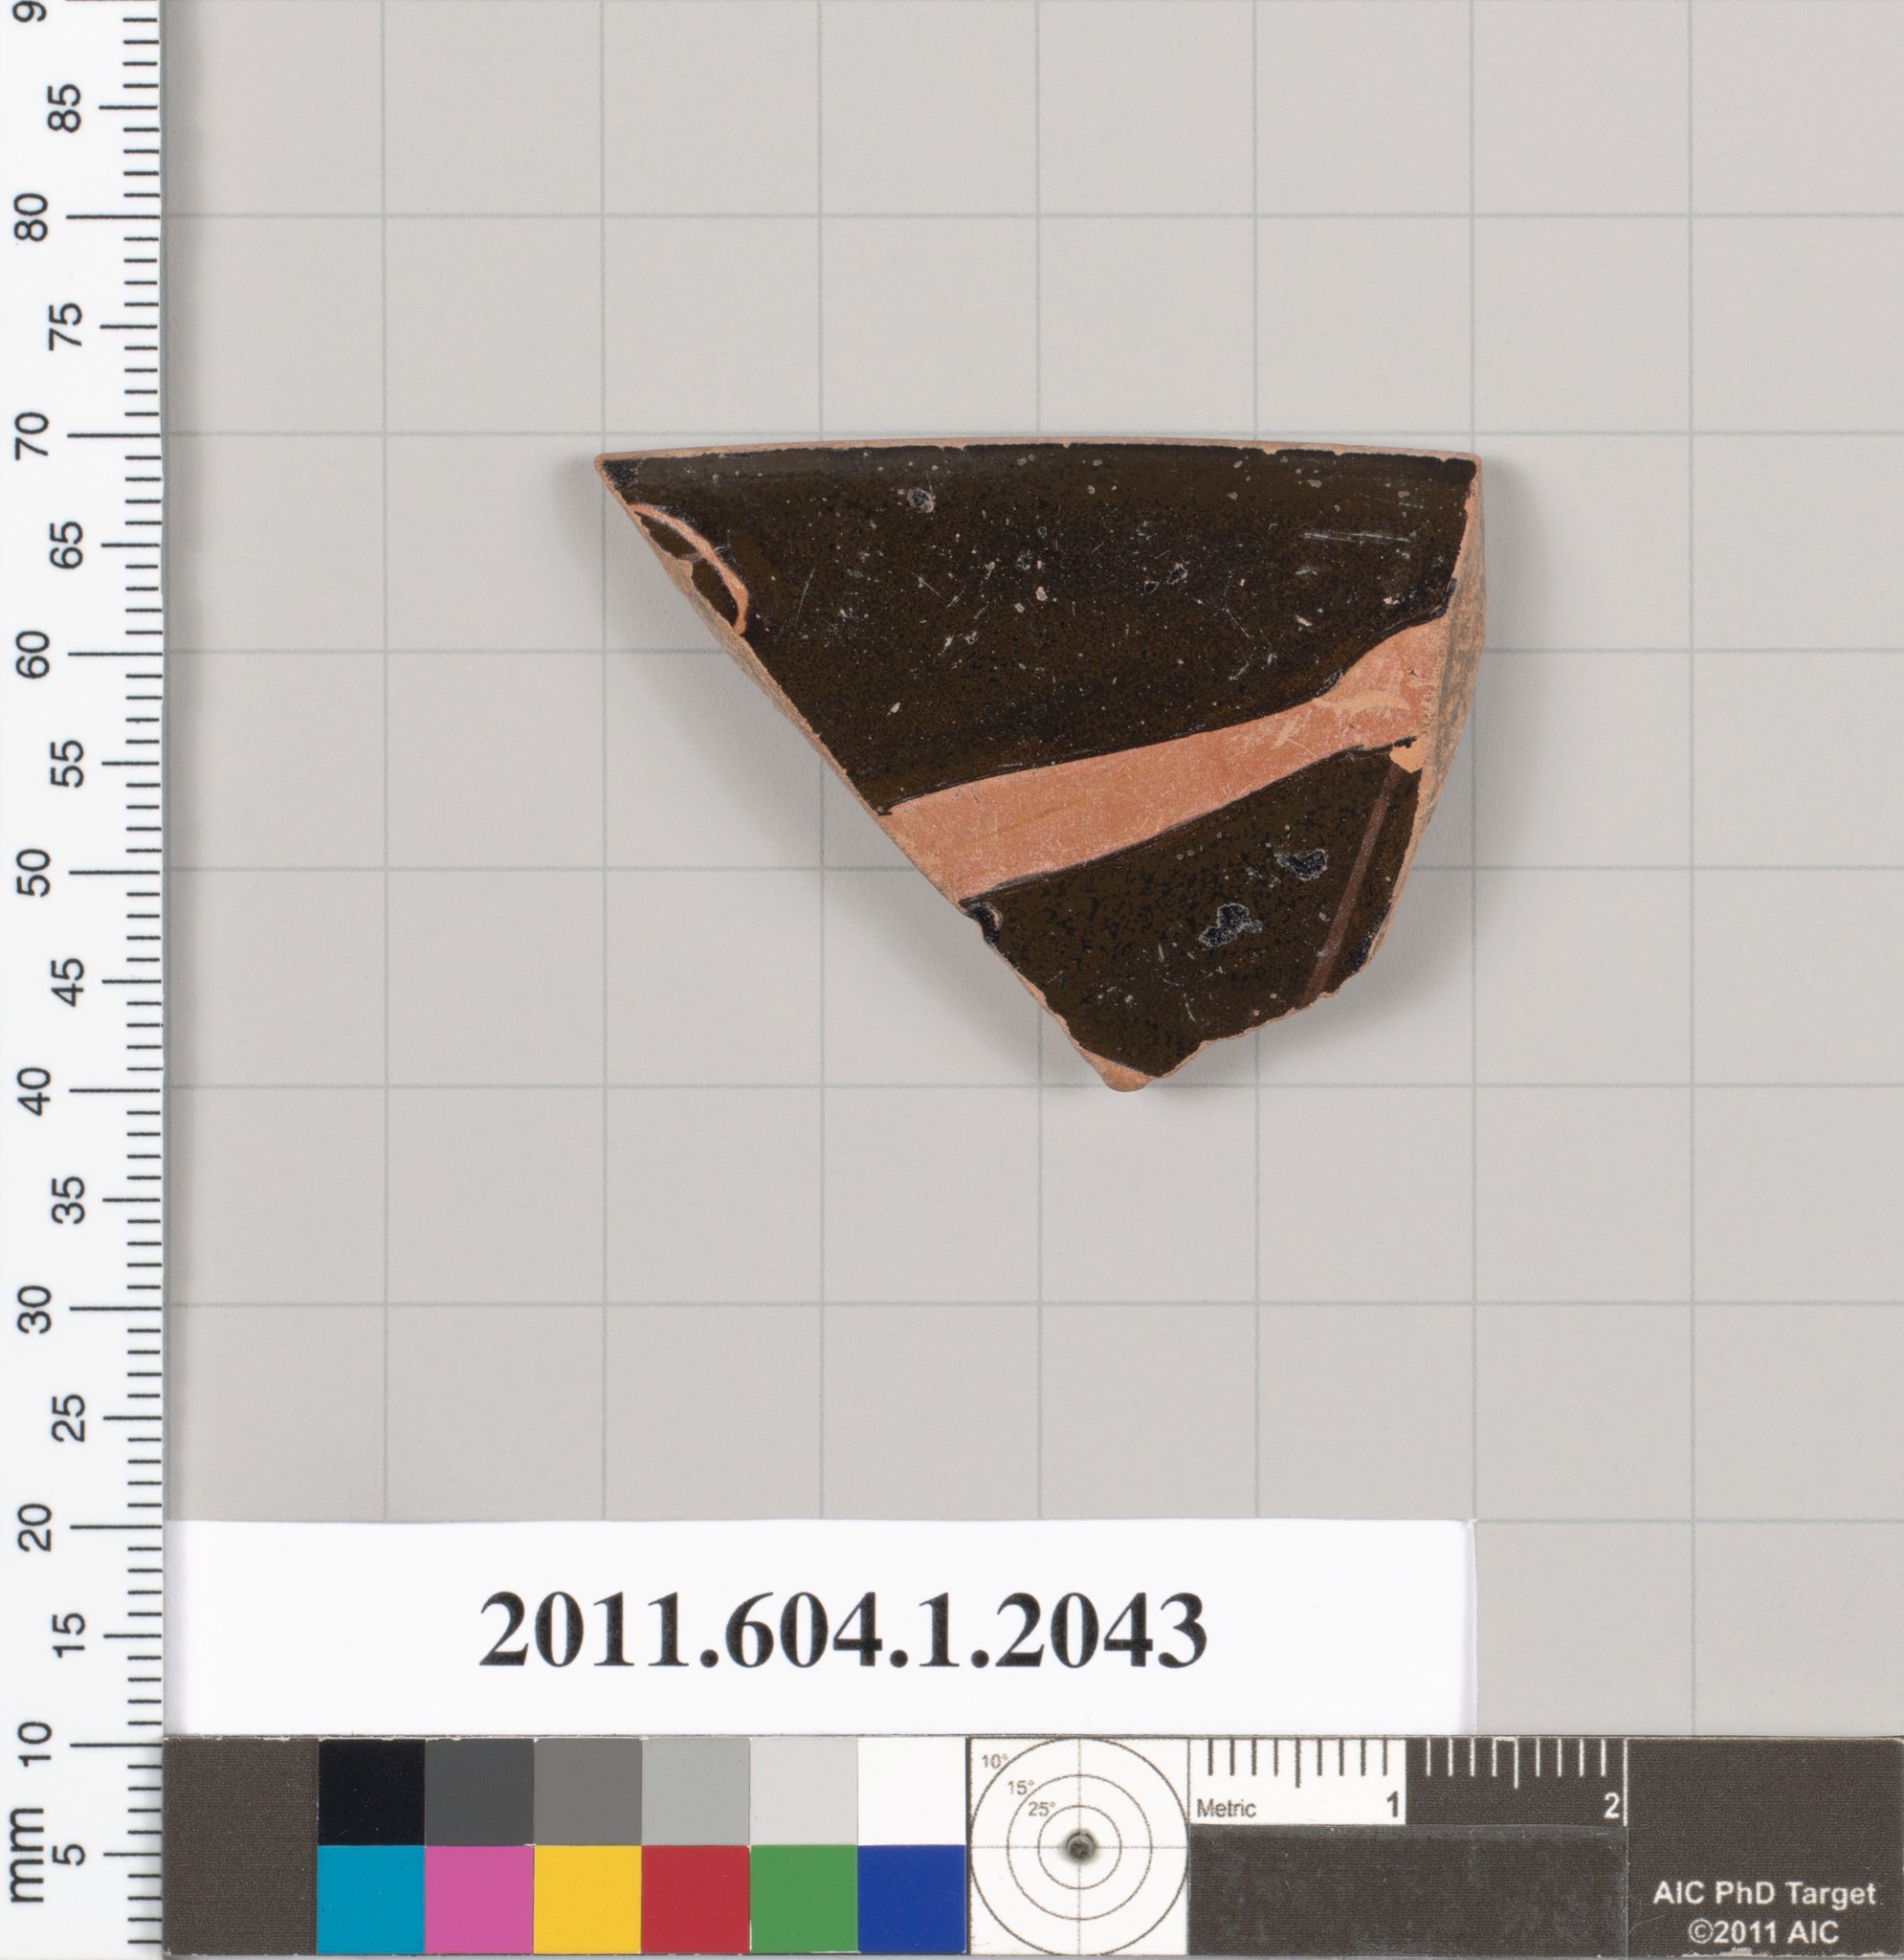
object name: kylix fragment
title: Terracotta rim fragment of a kylix (drinking cup)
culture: greek, attic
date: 475-451 BCE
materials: terracotta